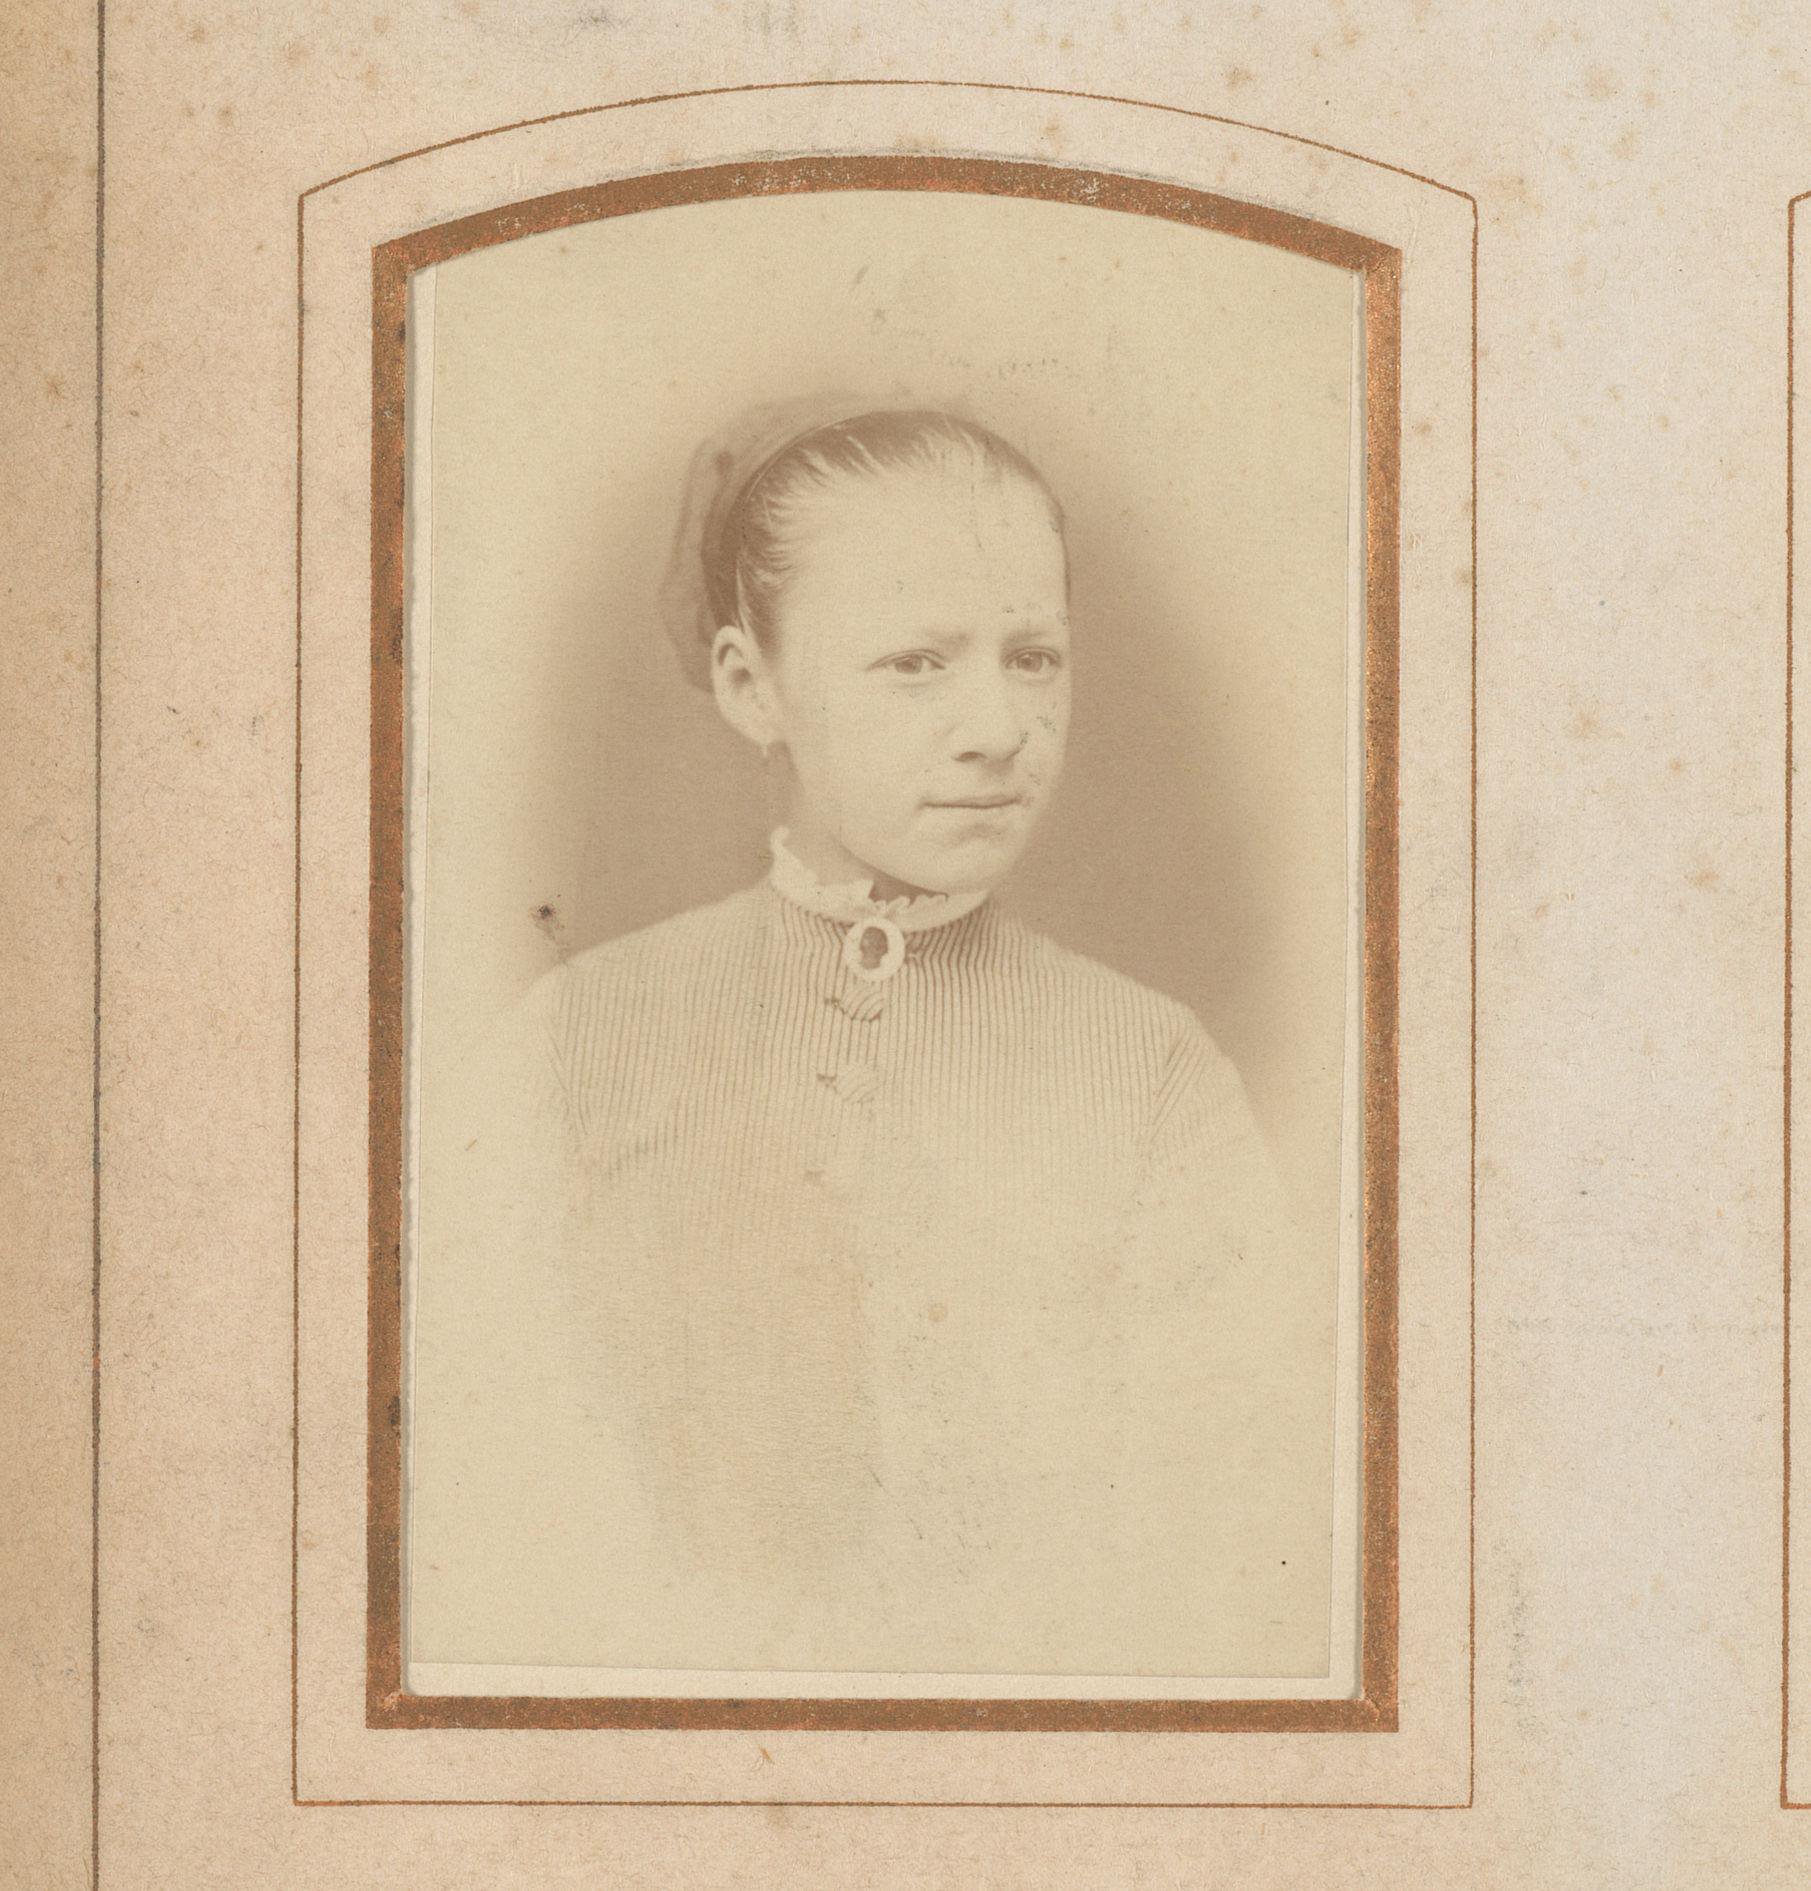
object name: album leaf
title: Portret van een meisje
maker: Anonymous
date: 1860-1900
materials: cardboard, photographic support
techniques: albumen print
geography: sweden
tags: historical persons - bb - woman, girl (child between toddler and youth)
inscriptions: name: ‘Aug. Schus[..]r’, annotation: ‘Zweeds’